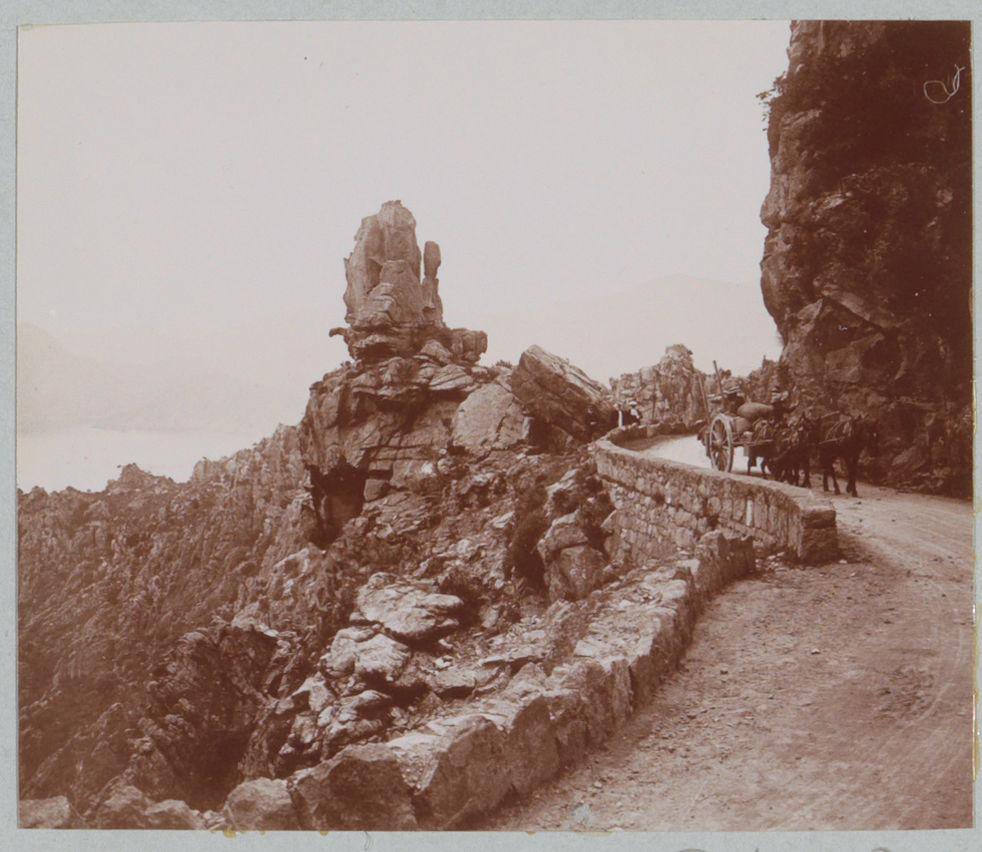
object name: photograph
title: Paard en wagen bij een rotsformatie, vermoedelijk op Corsica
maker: Anonymous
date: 1905-1910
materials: paper, photographic support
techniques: gelatin silver print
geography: corsica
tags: two-wheeled, animal-drawn vehicle, rock-formations, public road, mountains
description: Onderdeel van Fotoalbum van een Franse amateurfotograaf met bezienswaardigheden in Frankrijk, Zwitserland en Italië.